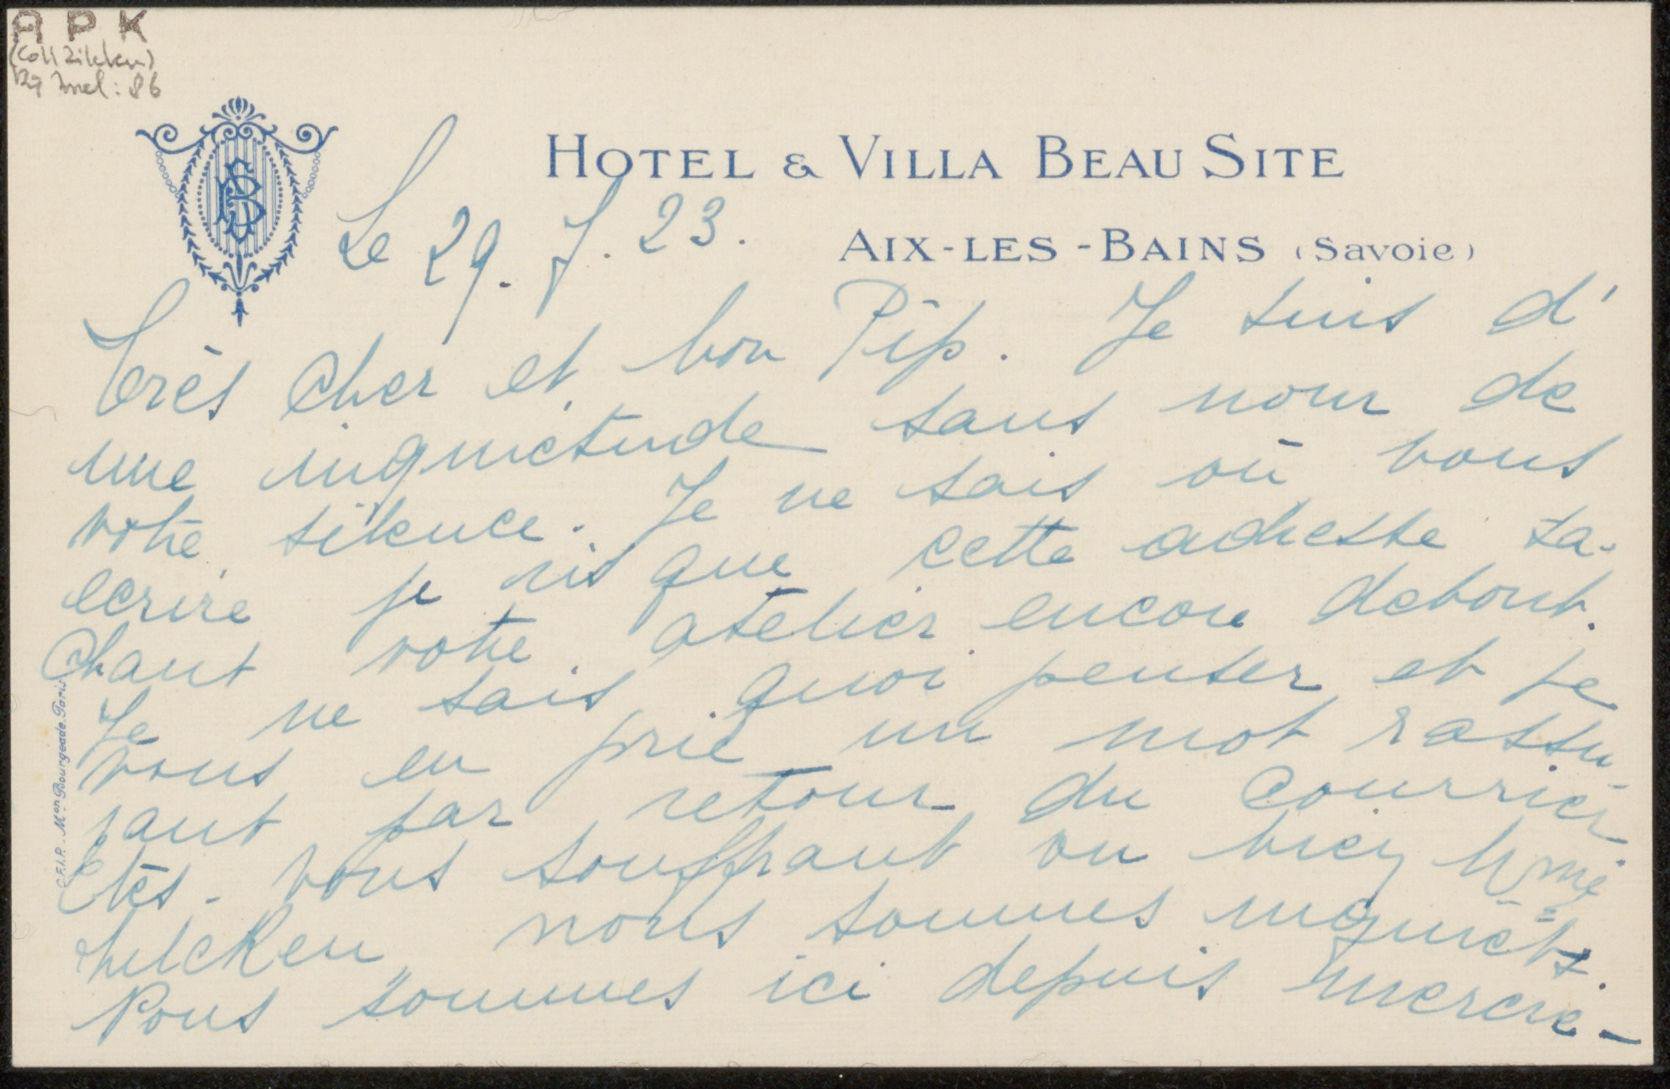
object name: letter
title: Brief aan Philip Zilcken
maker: rose imel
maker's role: draughtsman, painter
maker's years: 1901-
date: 1923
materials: cardboard, ink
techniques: pen, printing, writing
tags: the hague, painter, philip zilcken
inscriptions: collector's mark: ‘RPK’